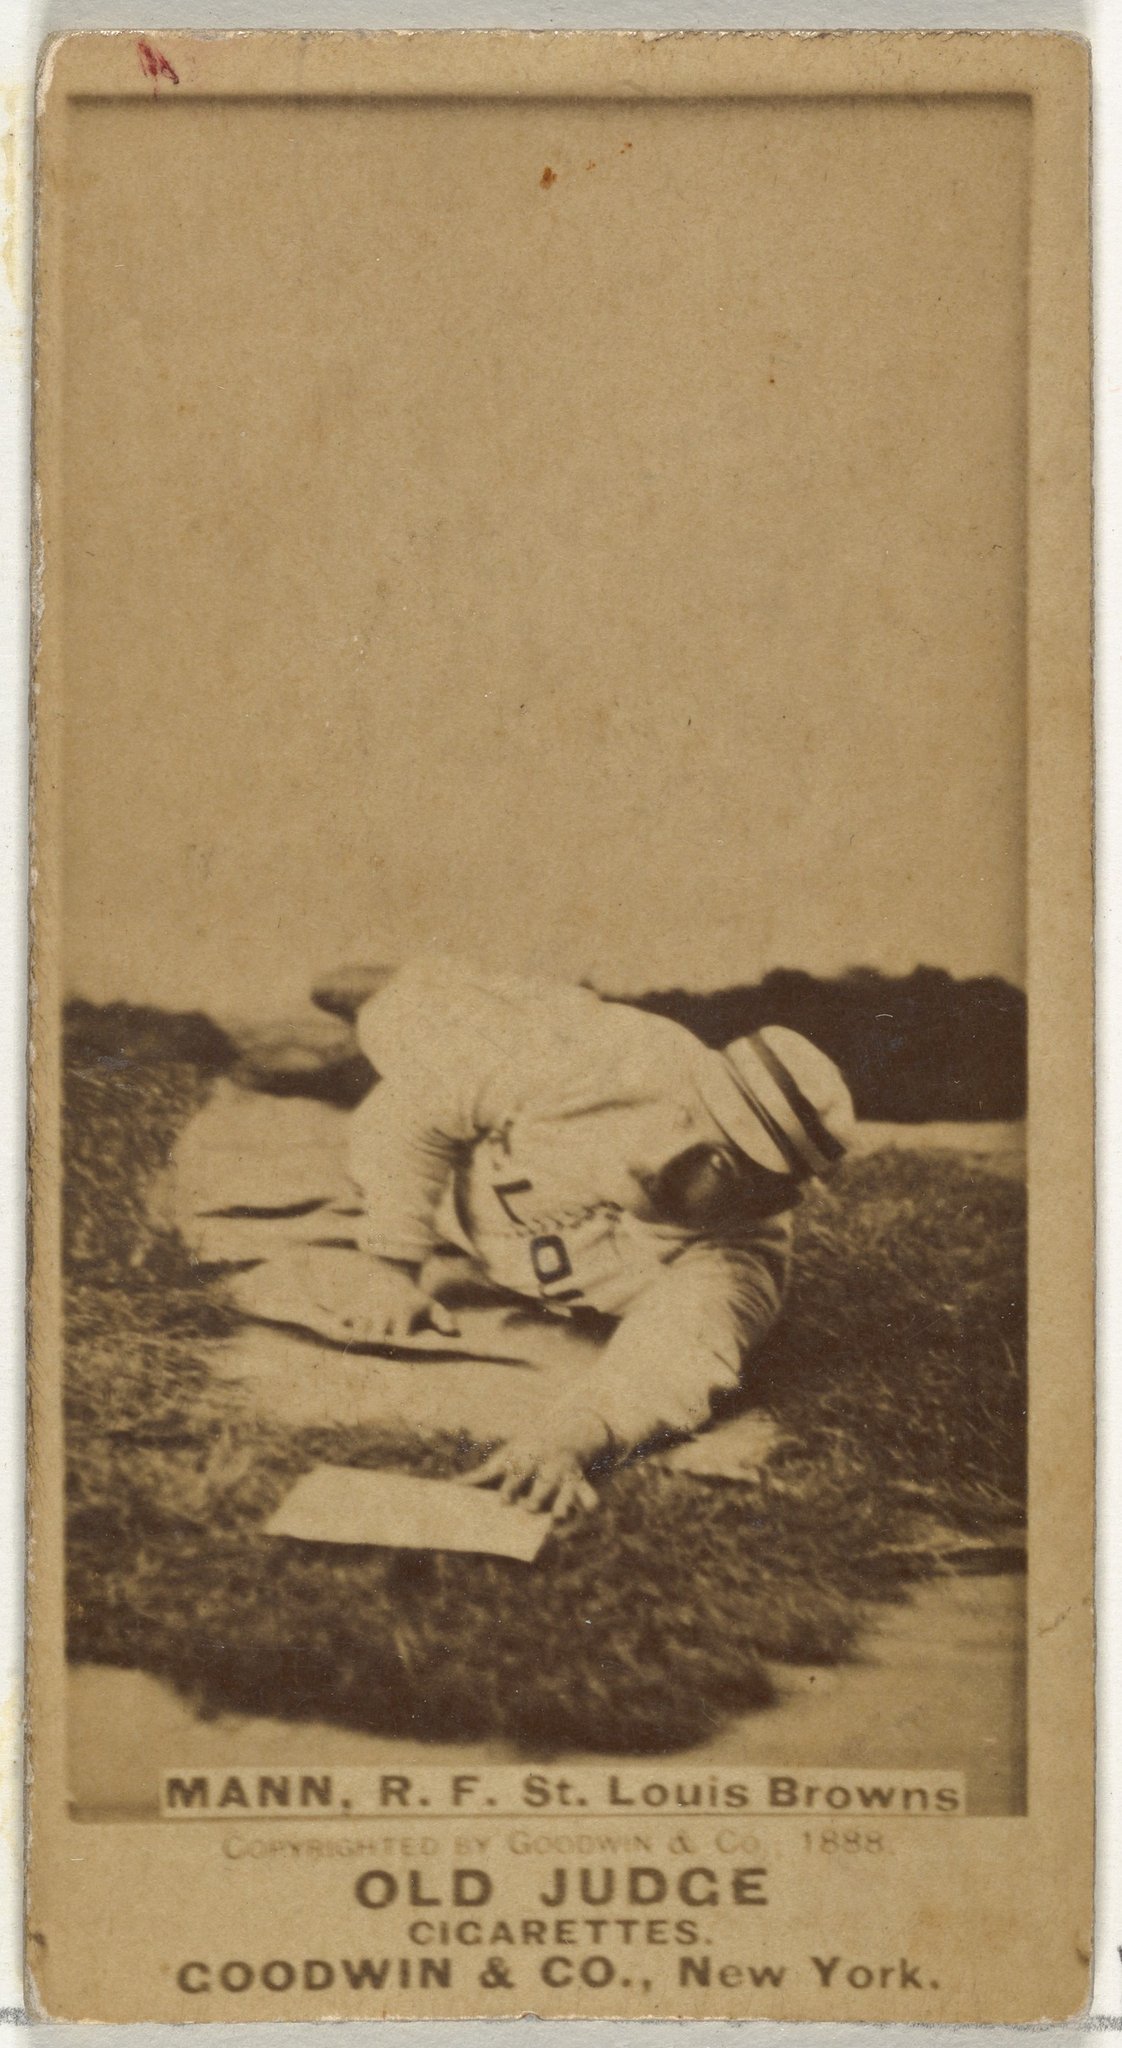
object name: baseball card, photograph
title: Mann, Right Field, St. Louis Browns, from the Old Judge series (N172) for Old Judge Cigarettes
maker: goodwin & company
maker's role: publisher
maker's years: 1850-1950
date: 1888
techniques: albumen silver print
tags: men,portraits,baseball,athletes